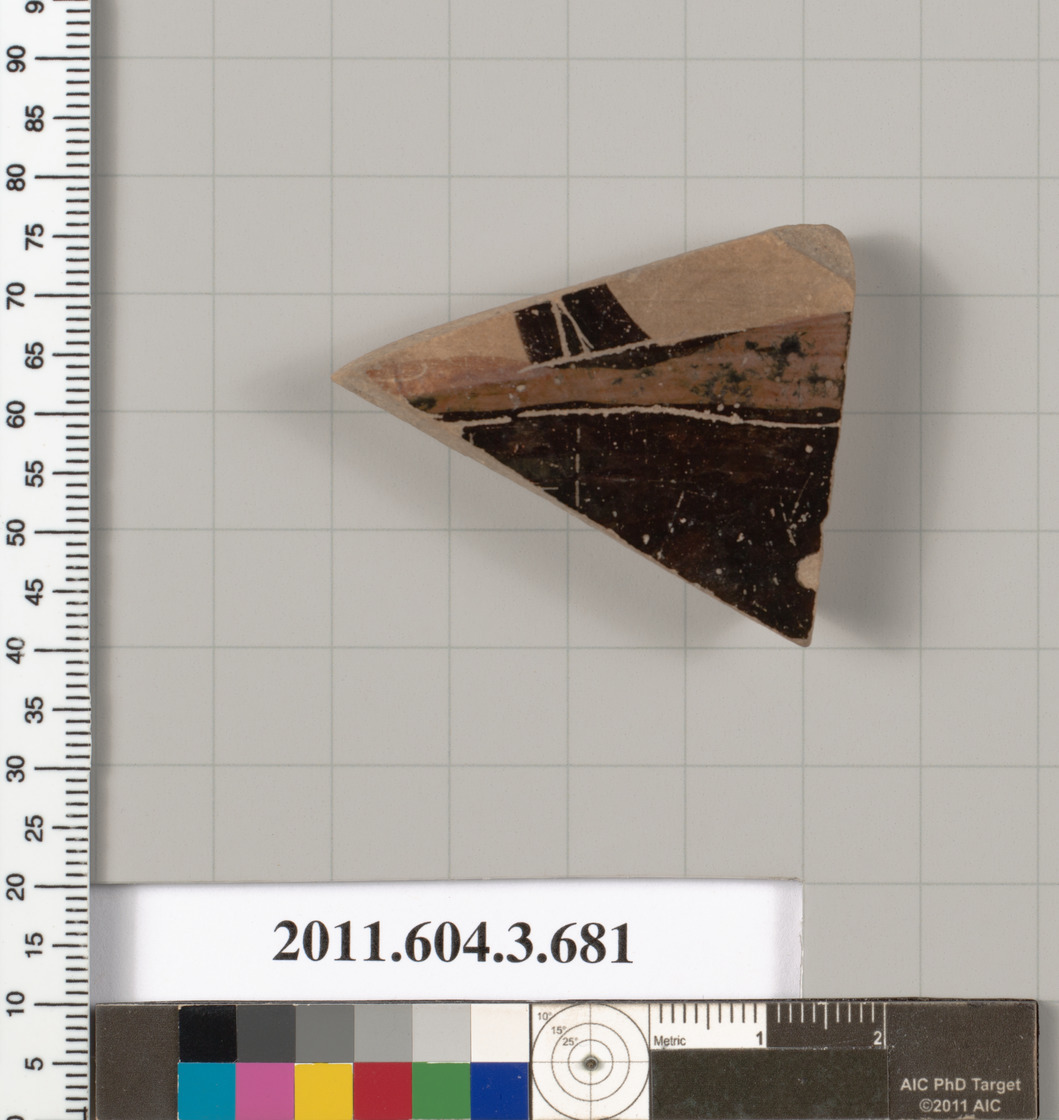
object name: stamnos fragment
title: Terracotta fragment of a stamnos (jar)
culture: greek, attic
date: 510-500 BCE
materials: terracotta